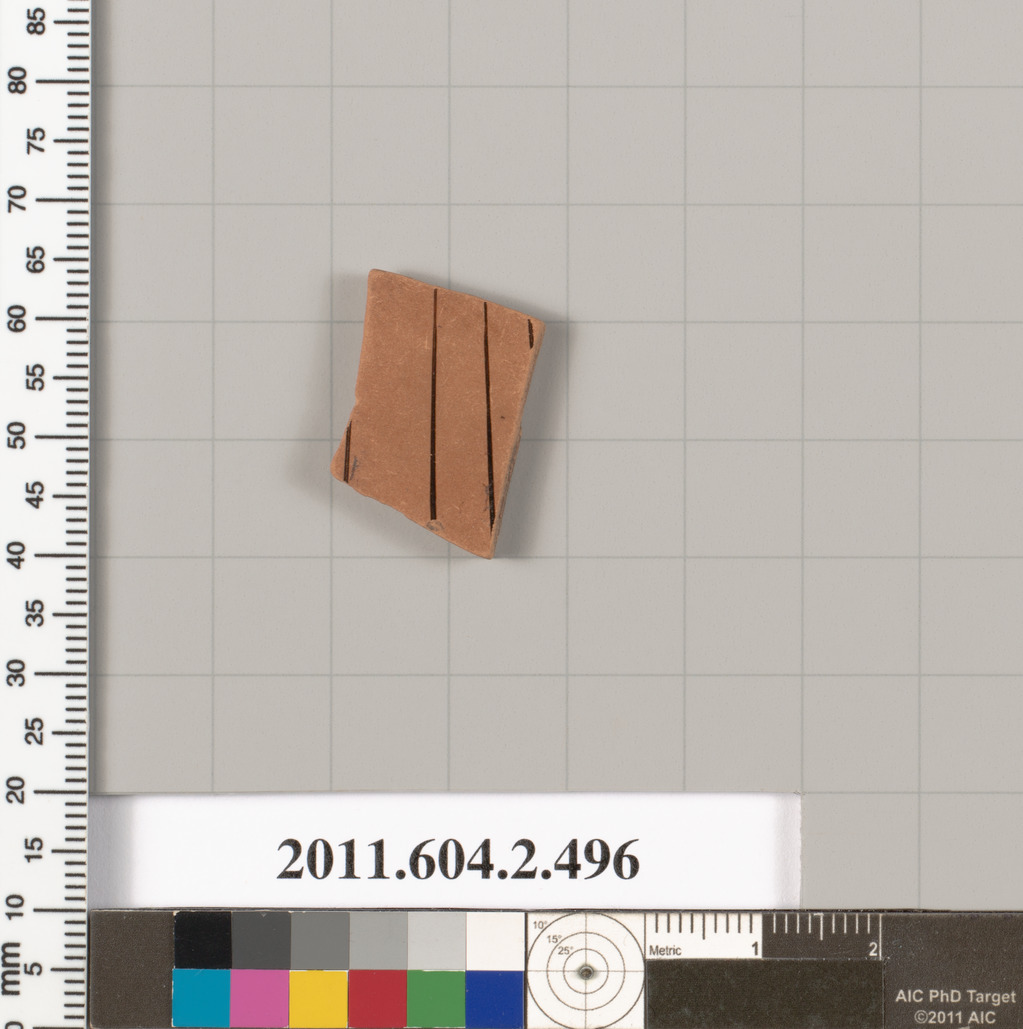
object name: column krater fragment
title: Terracotta fragment of a column-krater (bowl for mixing wine and water)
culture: greek, attic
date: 460-440 BCE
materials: terracotta